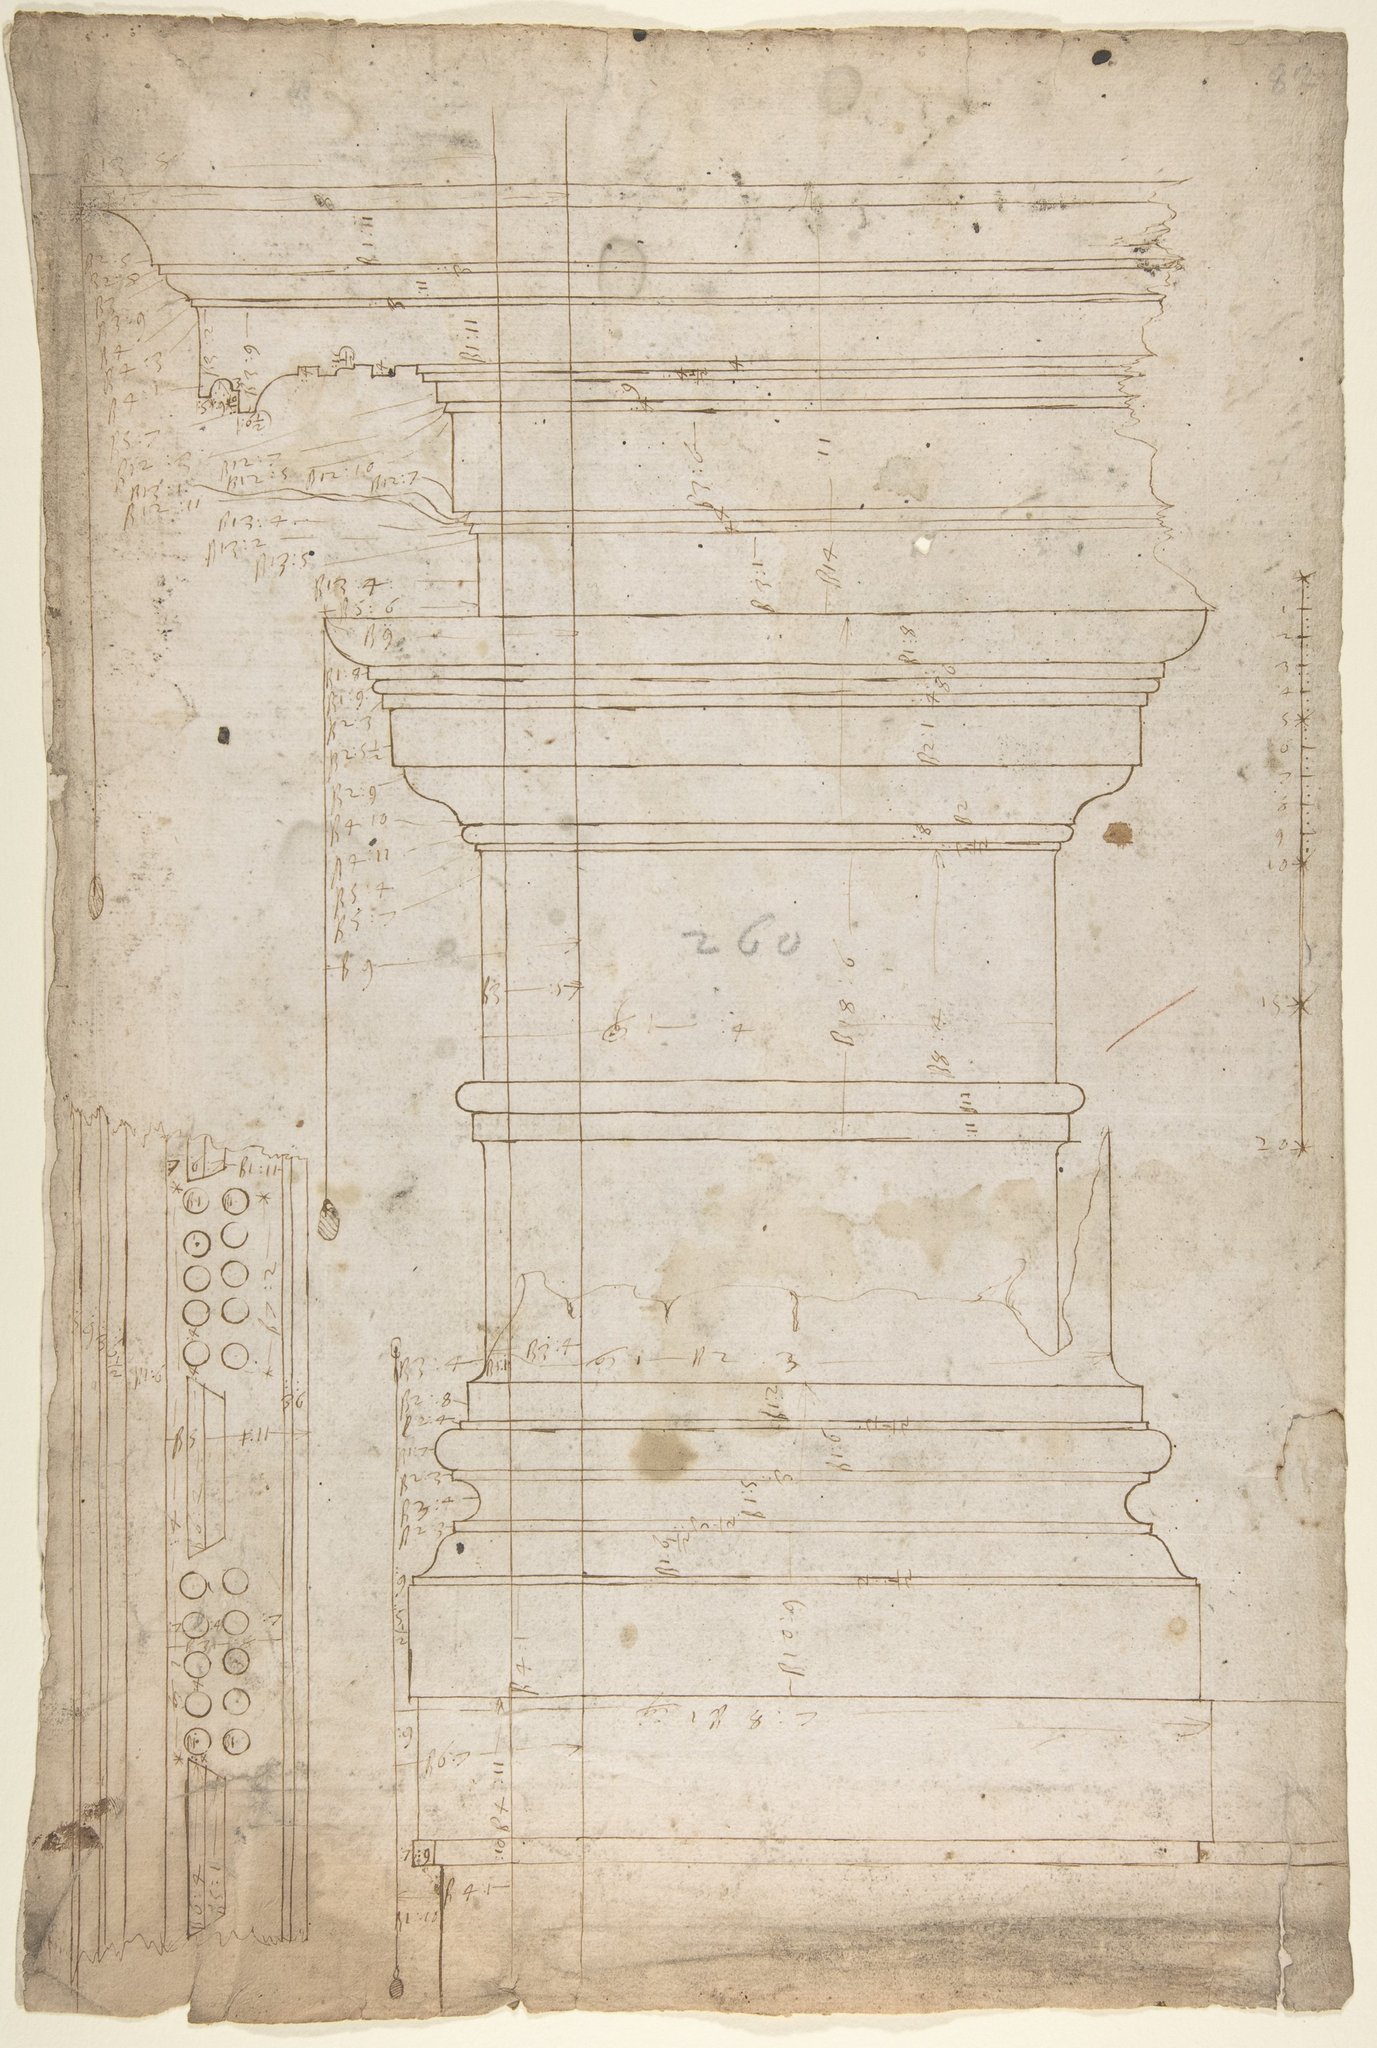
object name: drawing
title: San Lorenzo, Library, pilaster, elevation; soffit, detail, plan (recto) San Lorenzo, Library, entablature, section (verso)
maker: anonymous, french, 16th century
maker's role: draftsman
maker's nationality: french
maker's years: 1500-1600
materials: chalk, ink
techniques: incising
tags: architecture